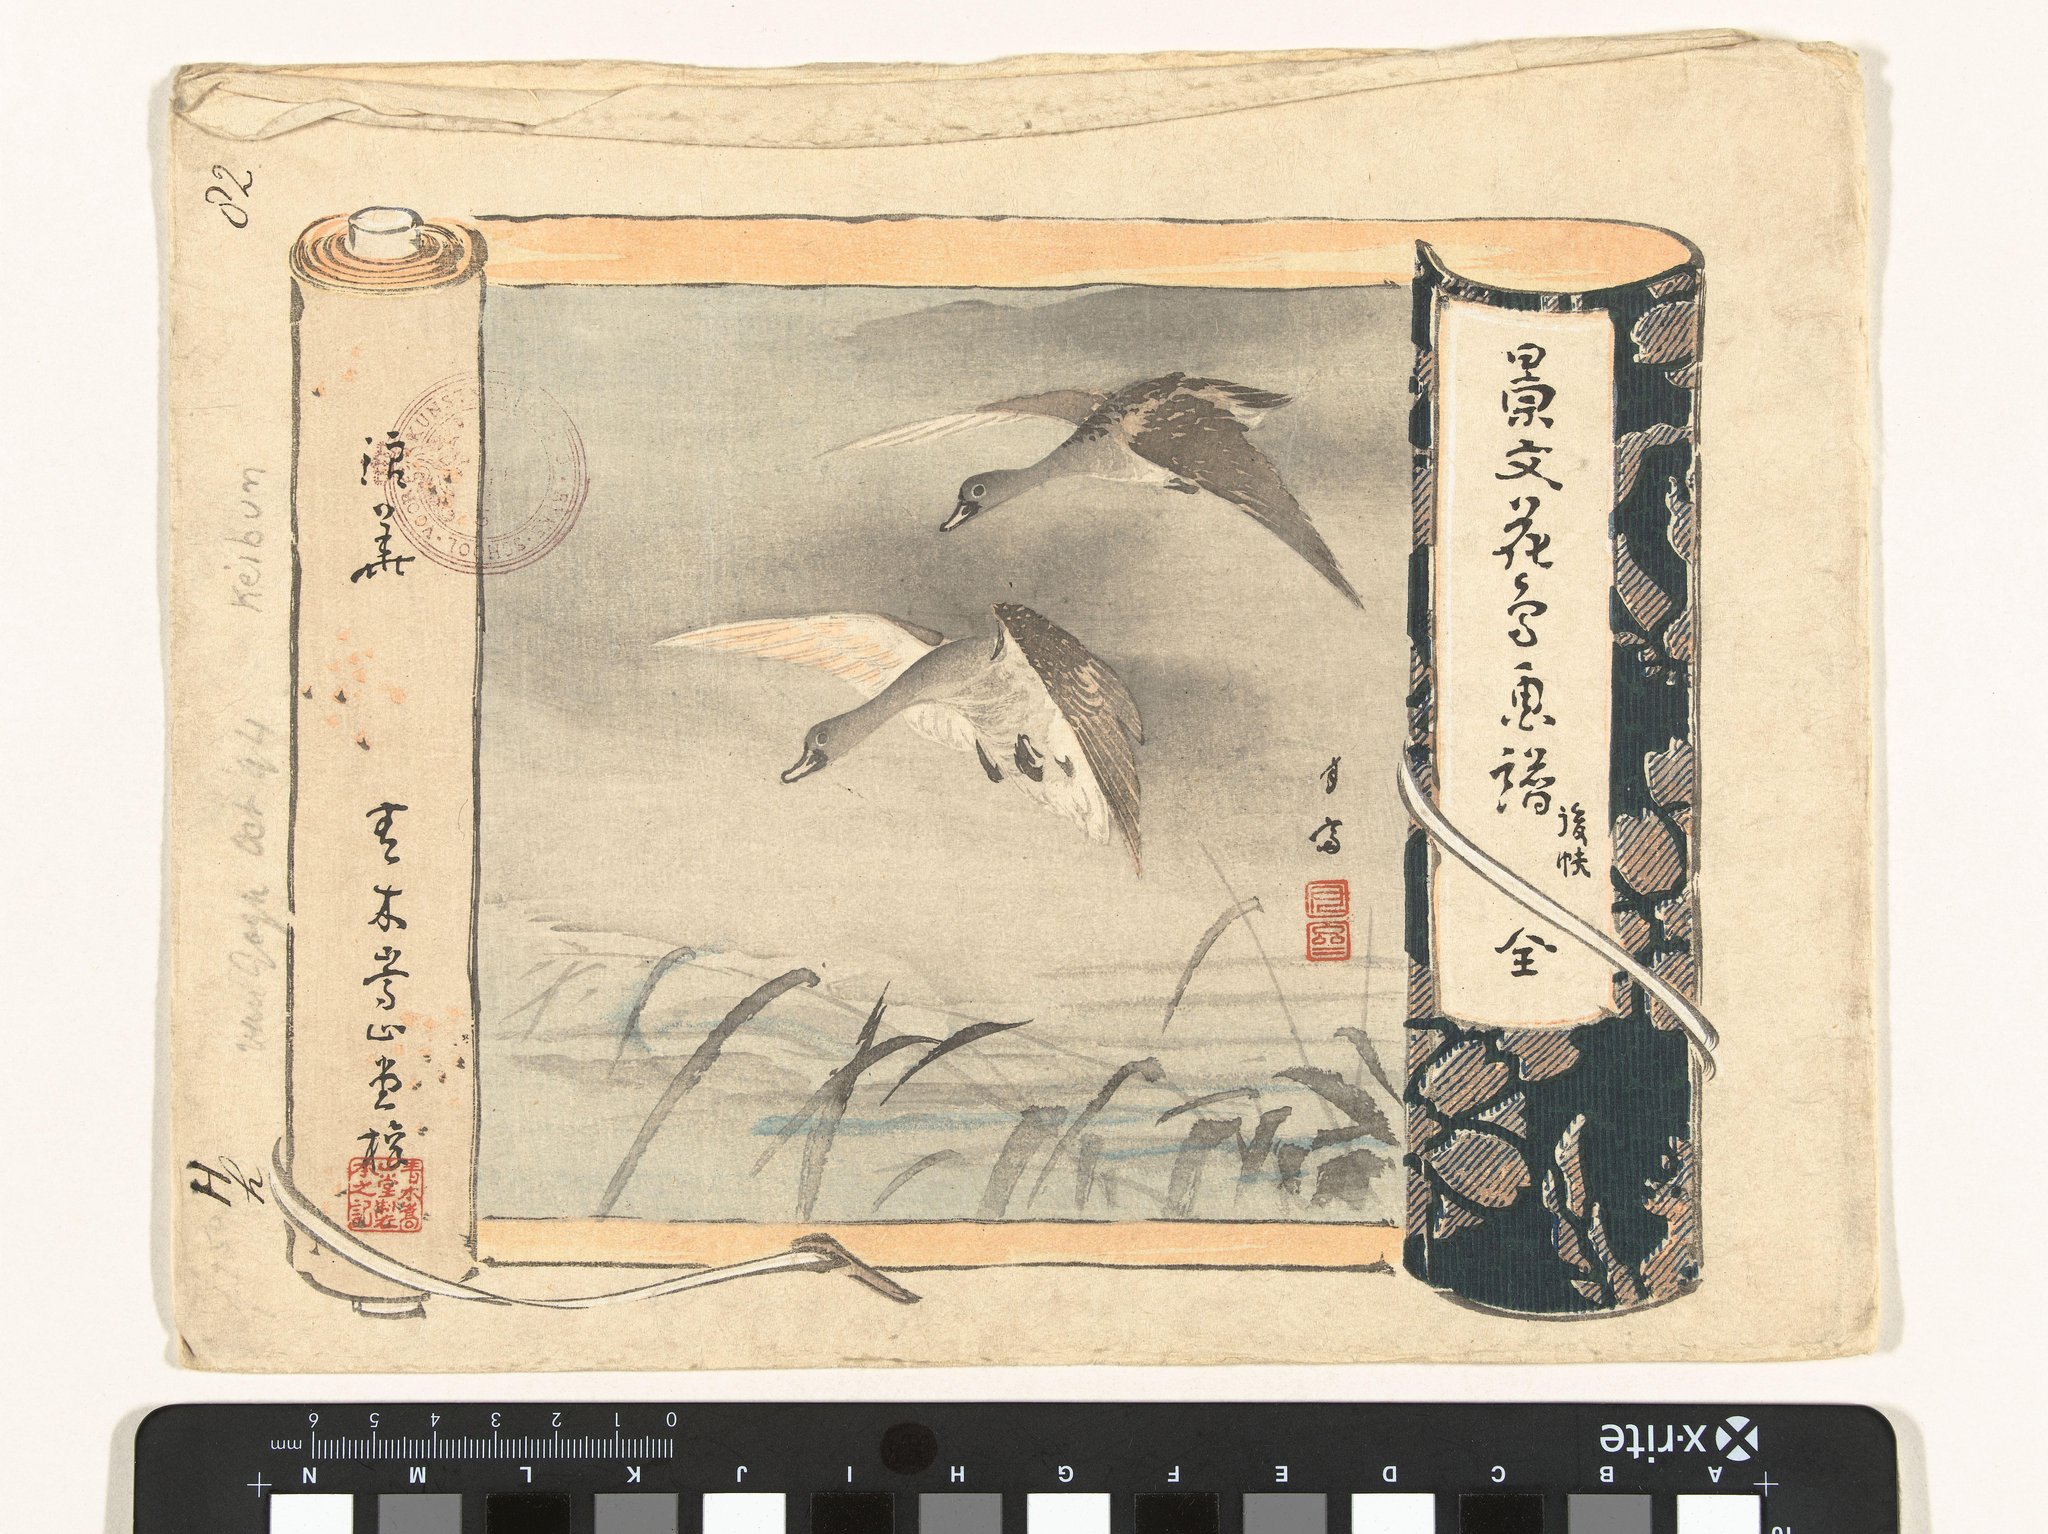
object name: print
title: Bloemen- en vogelschetsen van Keibun- deel drie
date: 1810-1892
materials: paper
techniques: woodcut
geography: osaka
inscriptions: collector's mark: Lugt 2228, collector's mark: ‘Rijksschool voor kunstnijverheid’ Lugt 3937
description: De originele omslag en tien prenten uit een serie van twaalf met afbeeldingen van vogels, bloemen en planten, naar Matsumura Keibun.